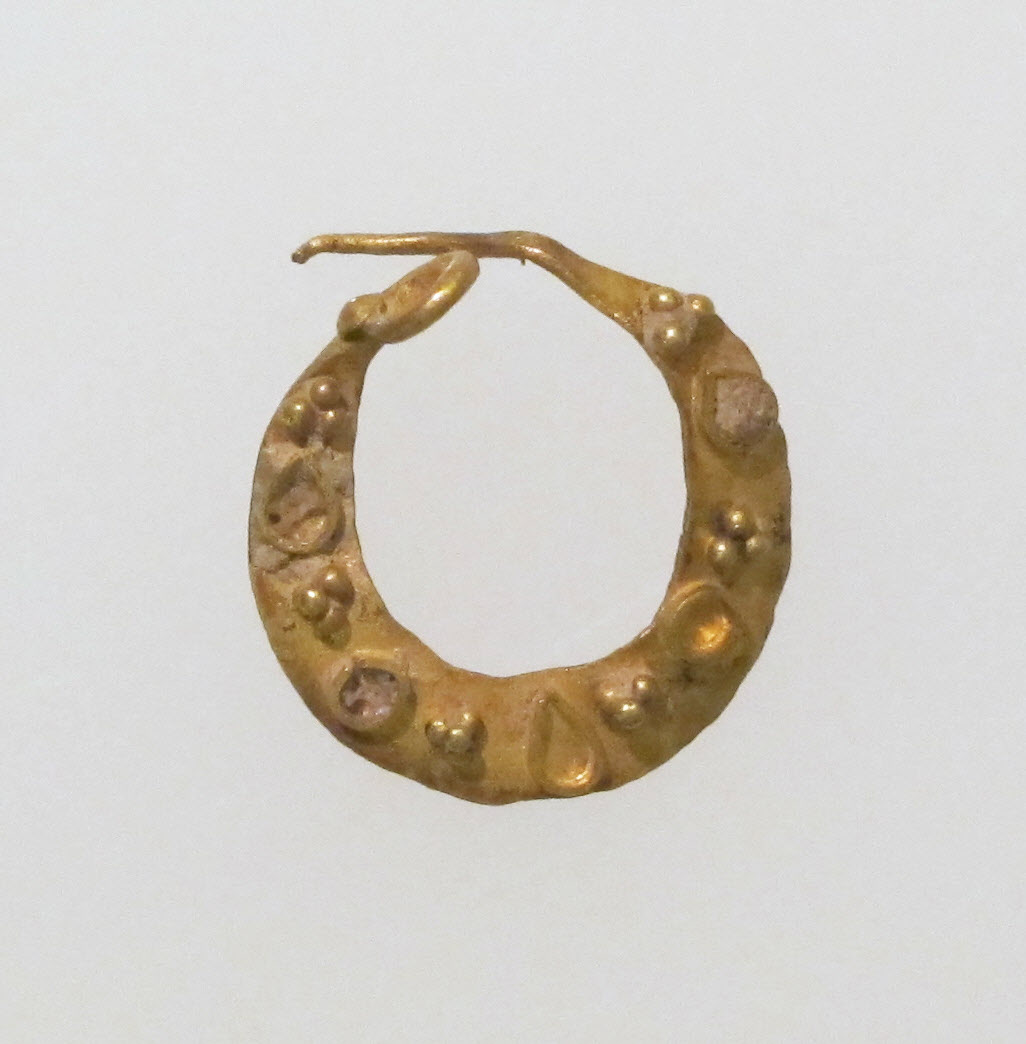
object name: earring, crescent shaped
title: Earring, crescent-shaped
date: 7000 BCE-330 CE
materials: gold